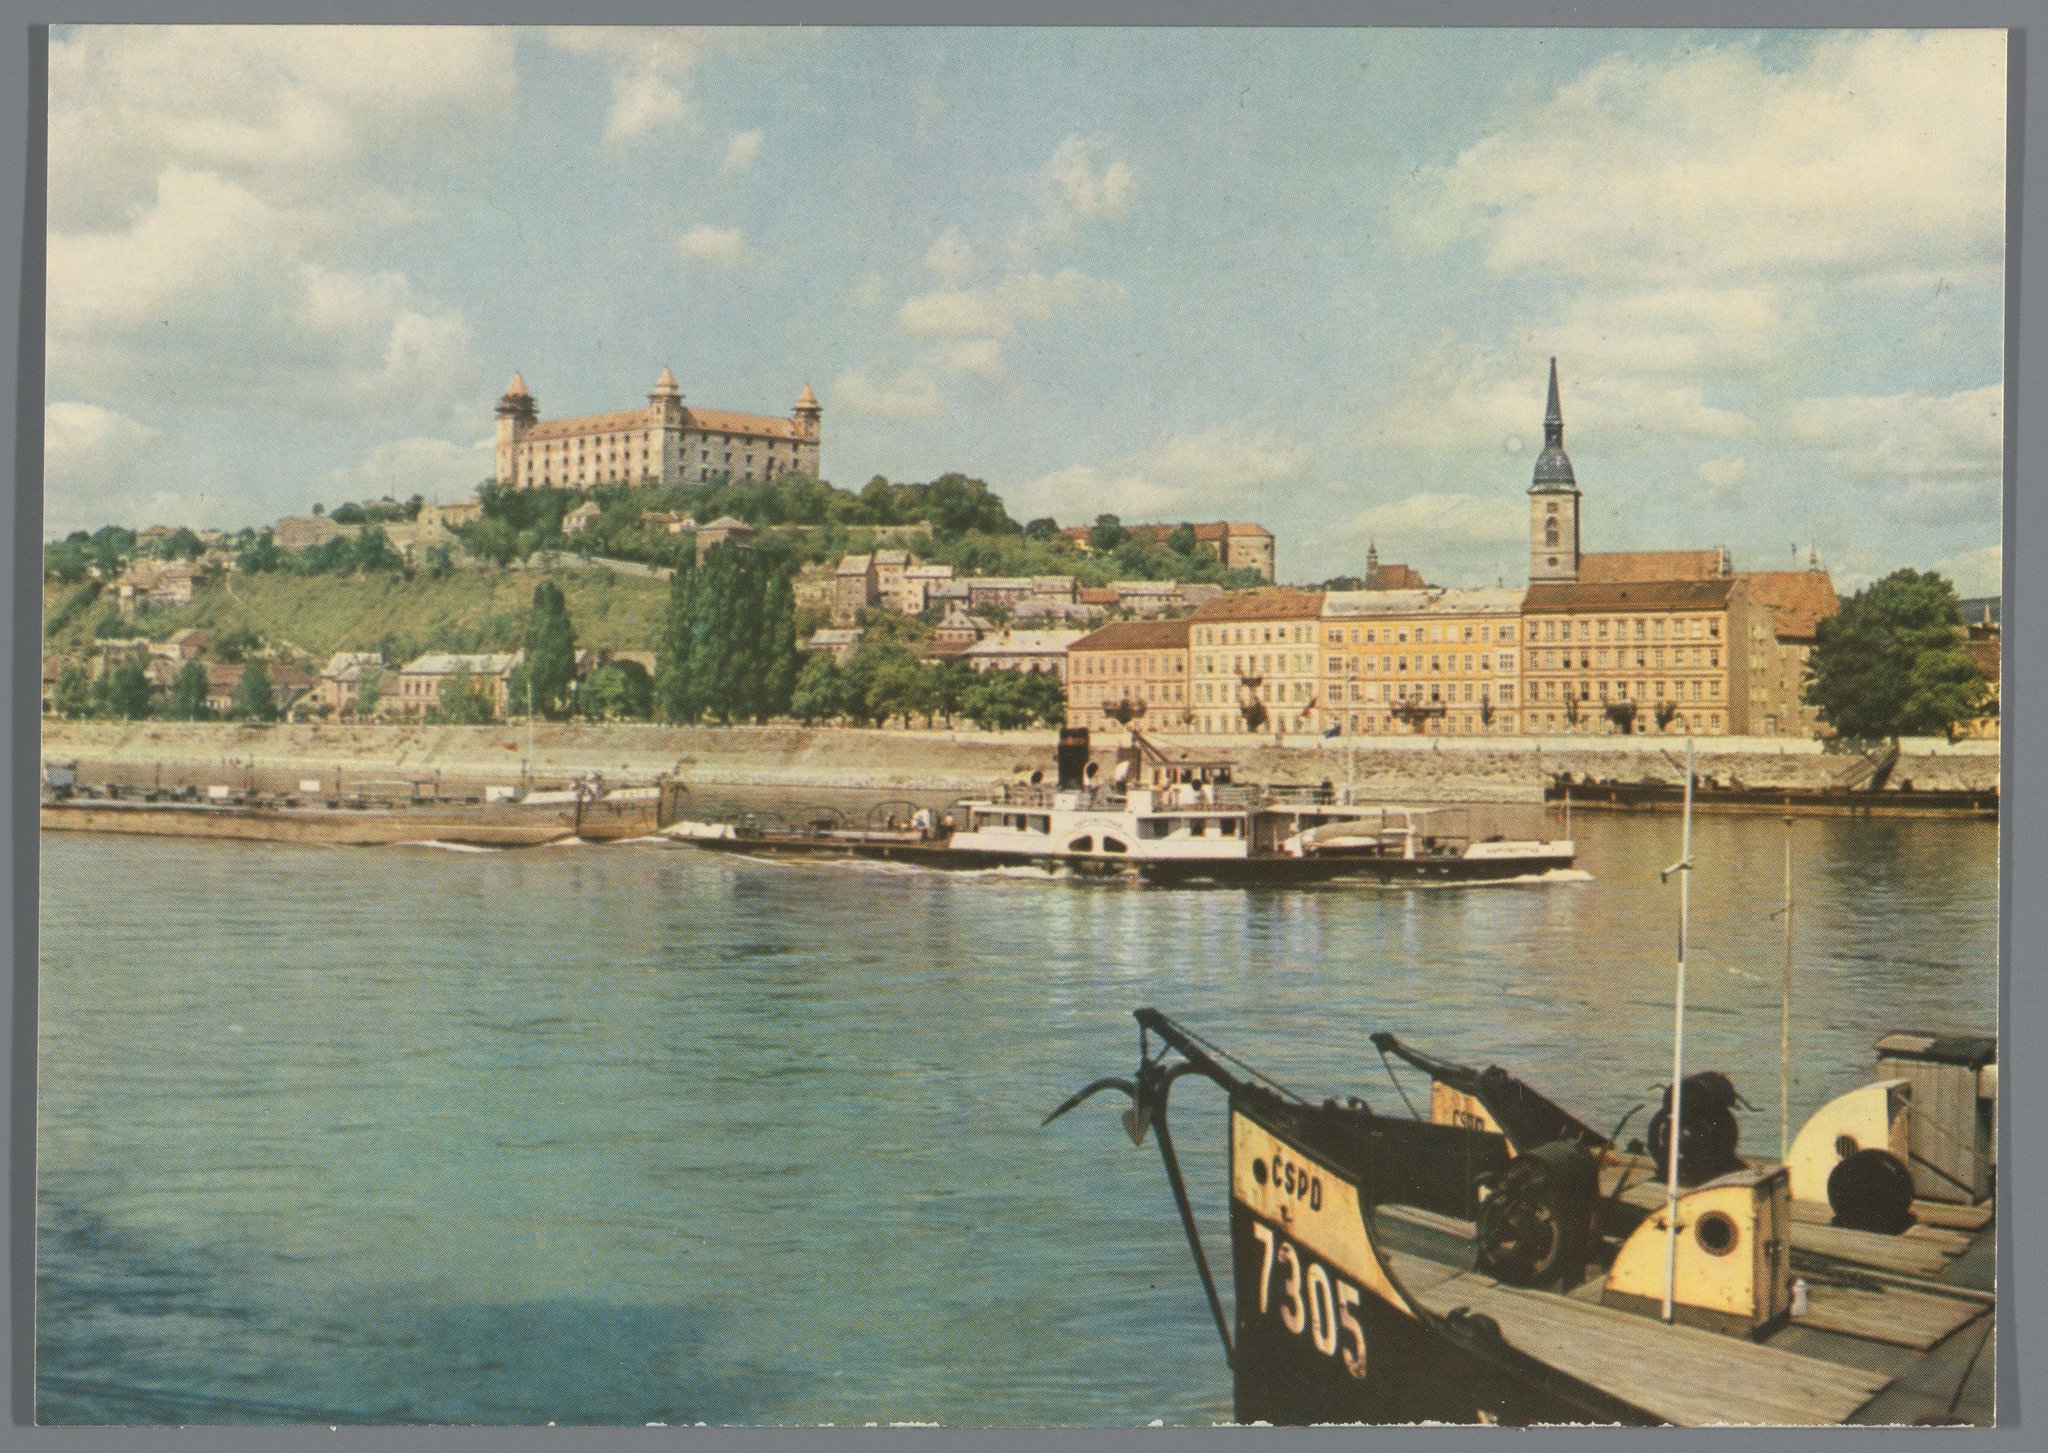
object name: photomechanical print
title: Donau en het kasteel van Bratislava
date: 1950-1980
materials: cardboard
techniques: four-color autotype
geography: bratislava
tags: castle, river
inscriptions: inscription: ‘Kcs 0.20/ V prospech cestovného ruchu’, inscription: ‘M 05-22824 (...) Kcs 0,60’